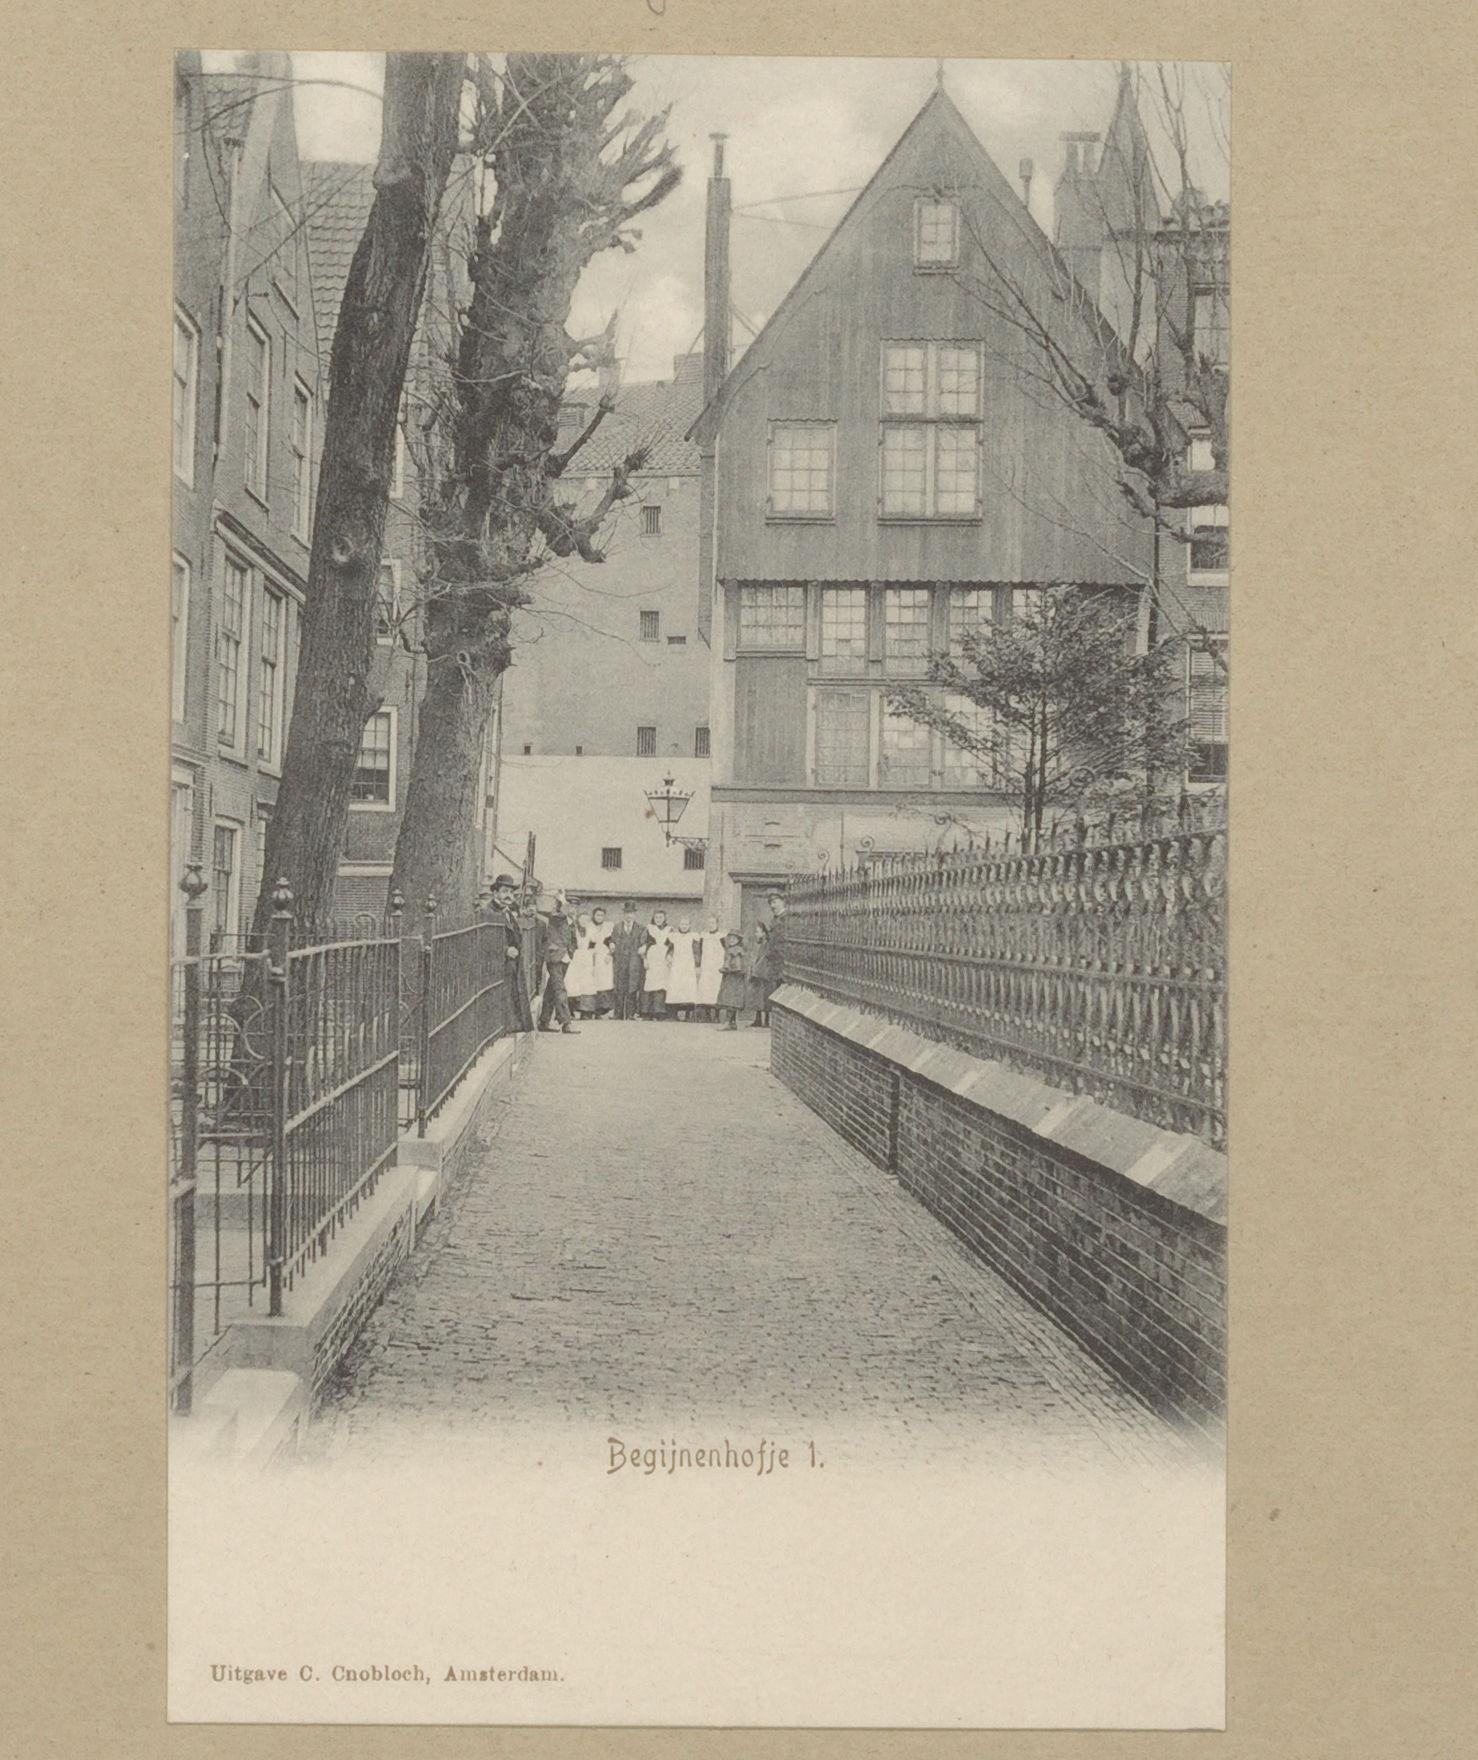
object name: ansichtkaart, prentbriefkaart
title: Gezicht op het Begijnhof te Amsterdam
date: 1892-1905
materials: paper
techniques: photograph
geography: netherlands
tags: street (+ city(-scape) with figures, staffage)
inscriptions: collector's mark: Lugt 1641b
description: Onderwerpsrubriek binnen de Atlas Amsterdam: Kerkwezen: R.K. Gemeenten: Begijnhof t/m Petrus en Paulus.